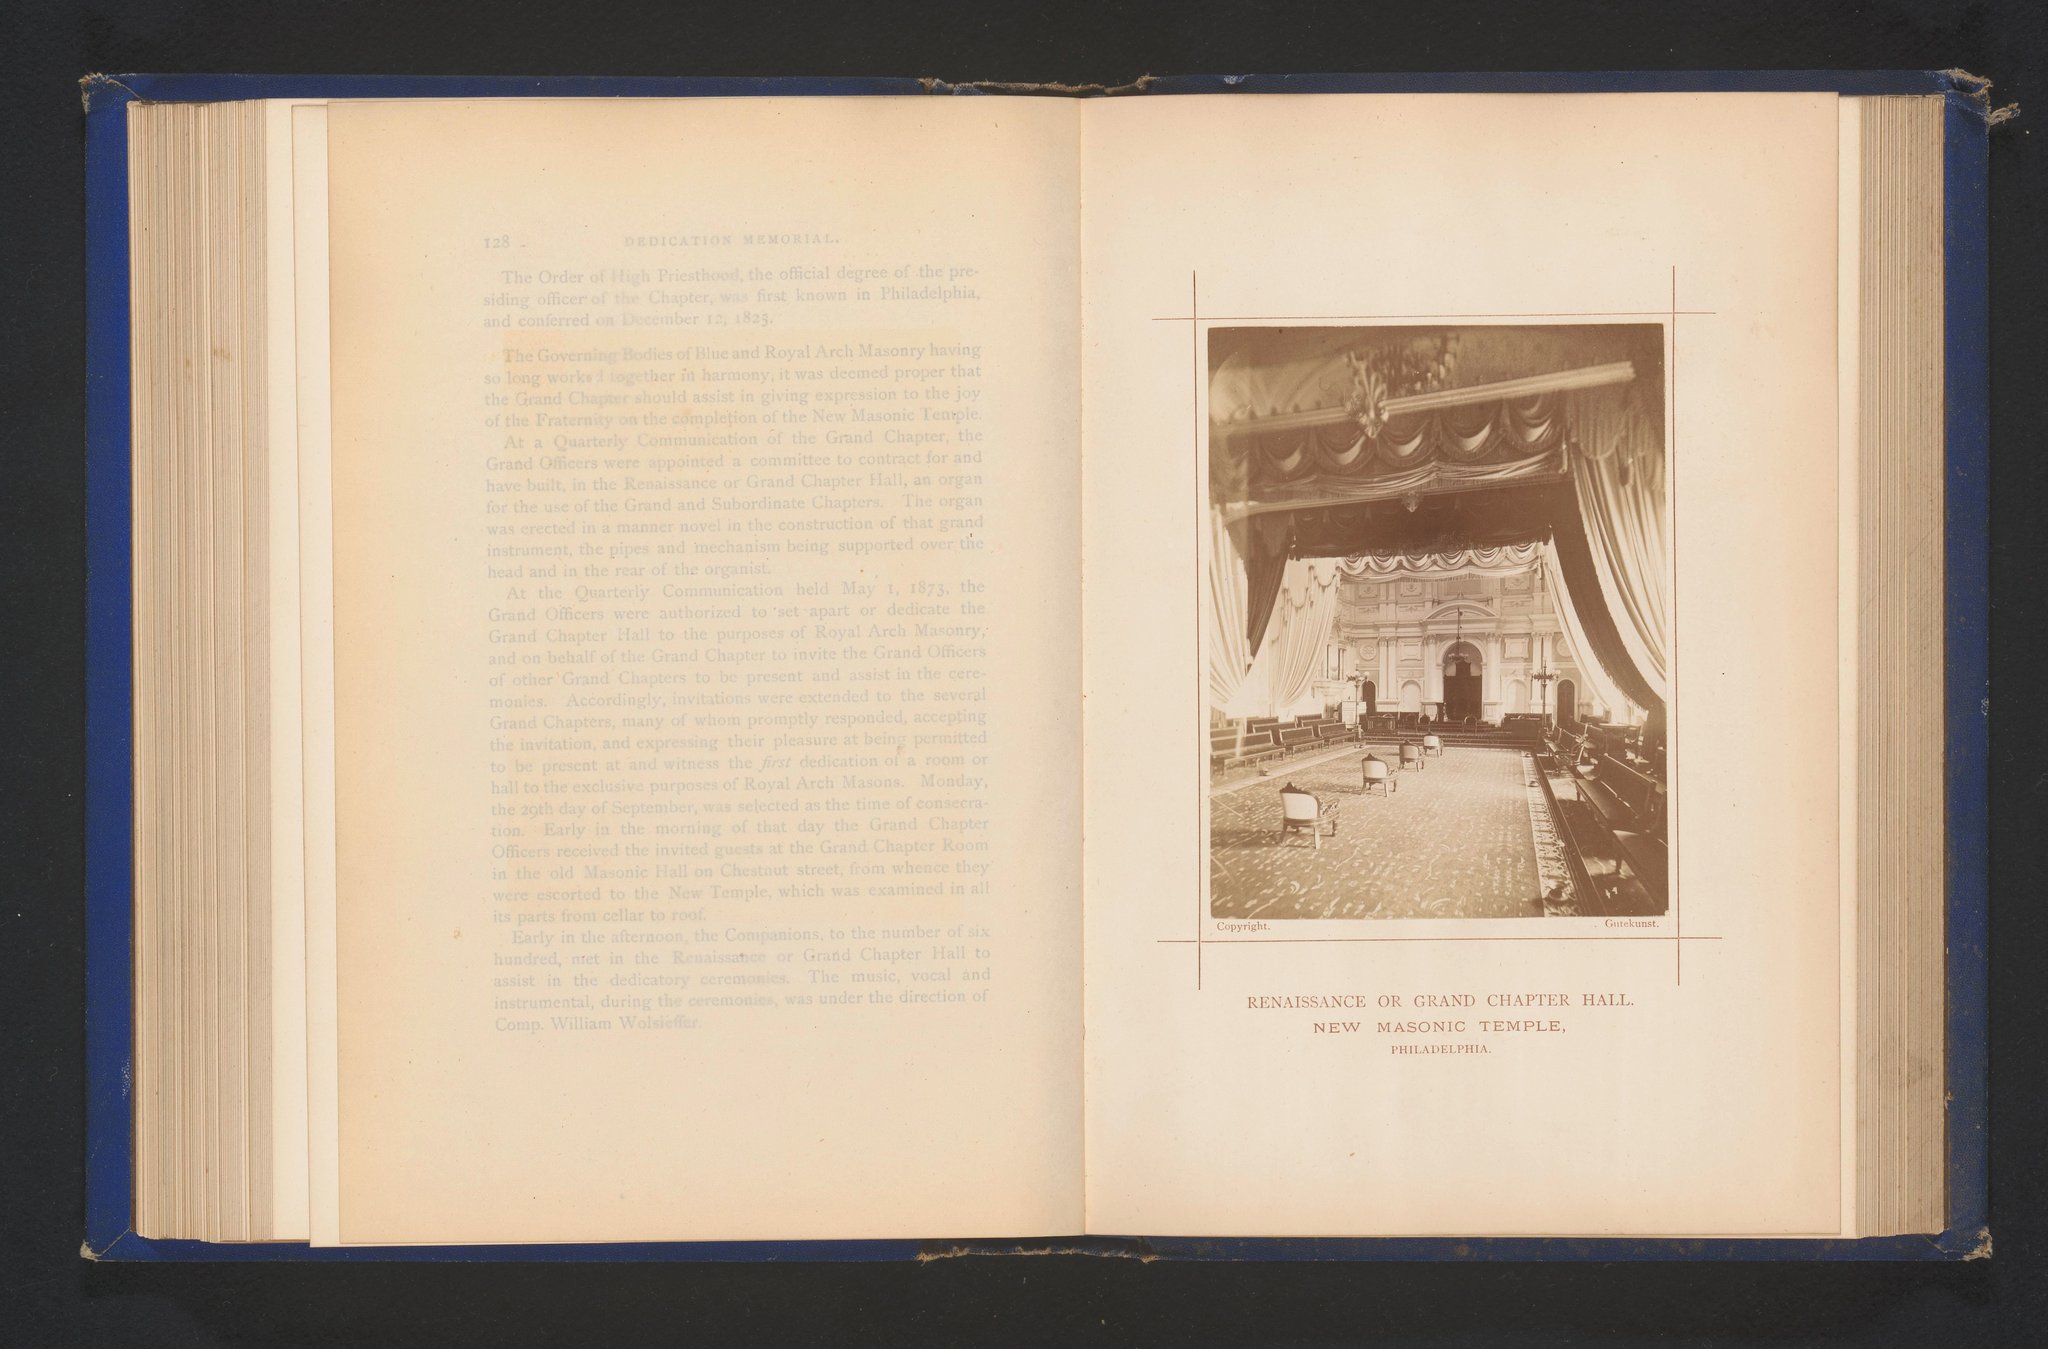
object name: photograph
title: Renaissance or grand chapter hall. New Masonic Temple, Philadephia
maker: frederick gutekunst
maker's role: fotograaf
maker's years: 1831-1917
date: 1869-1874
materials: photographic support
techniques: albumen print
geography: philadelphia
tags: vestibule, hall, miscellaneous religions, cults and doctrines: freemasonry